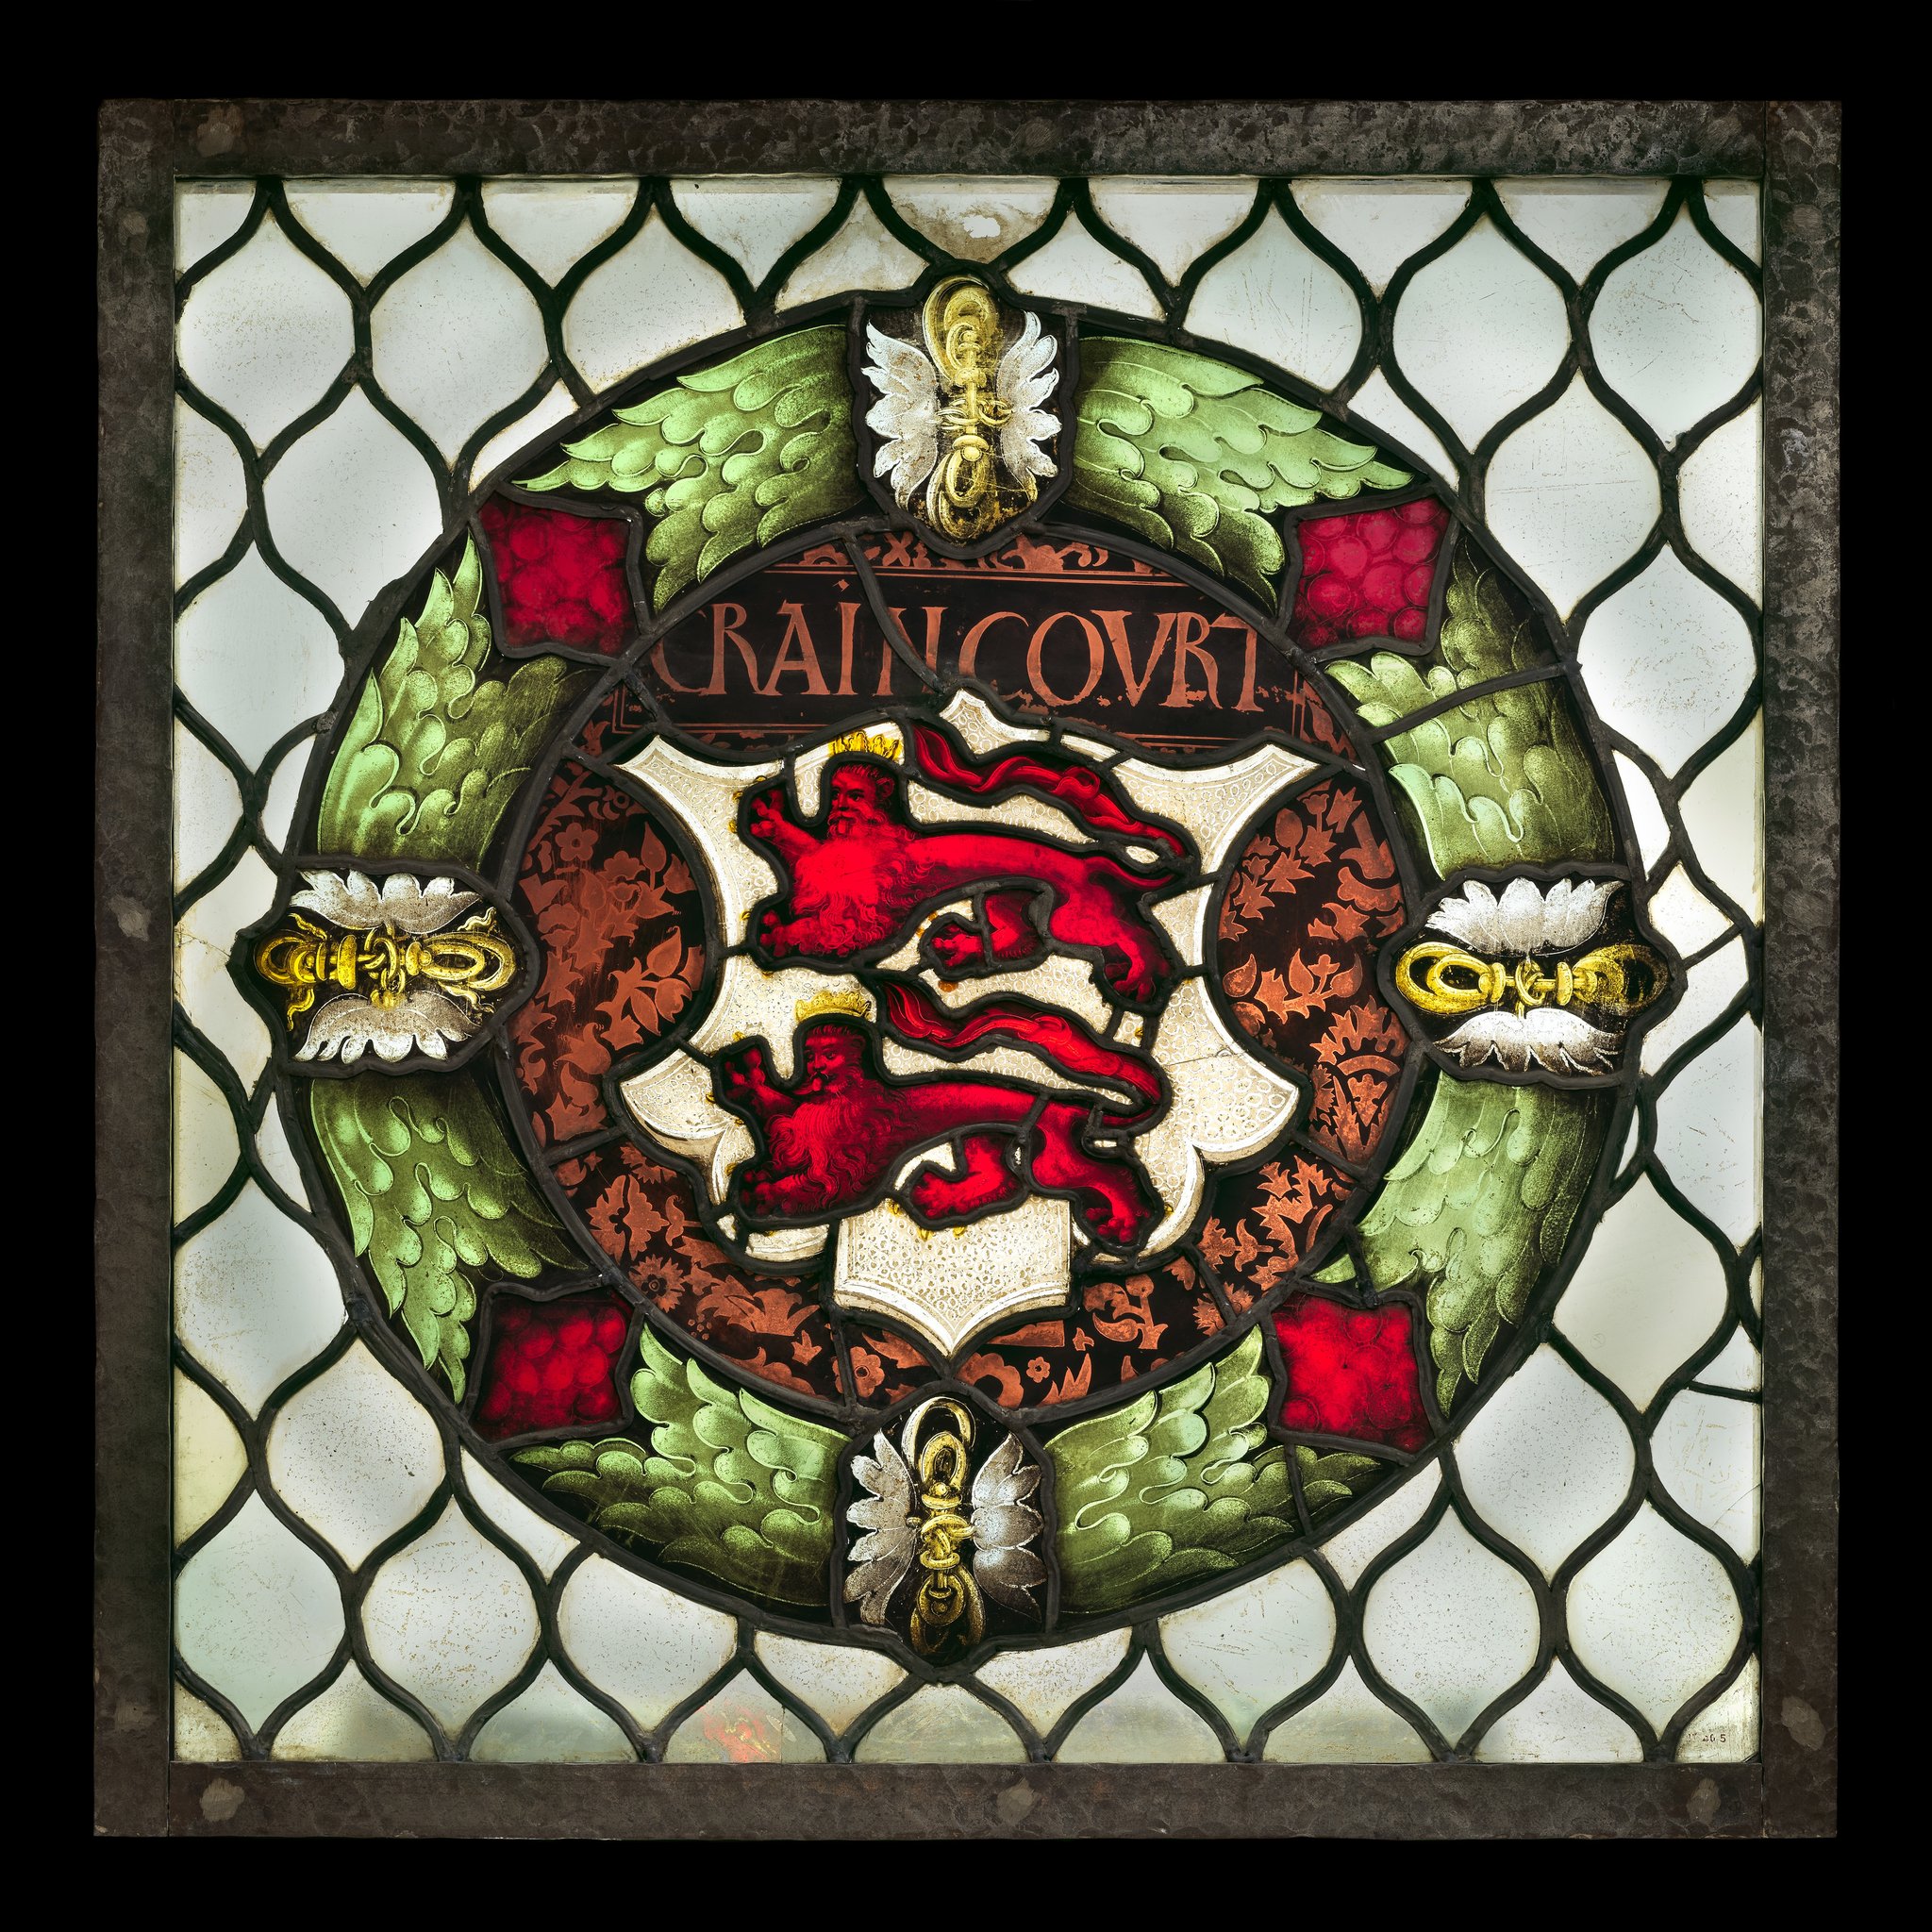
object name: armorial medallion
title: The Craincourt Arms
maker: valentin bousch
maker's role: artist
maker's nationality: french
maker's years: 1514-1541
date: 1533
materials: glass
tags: lions,coat of arms